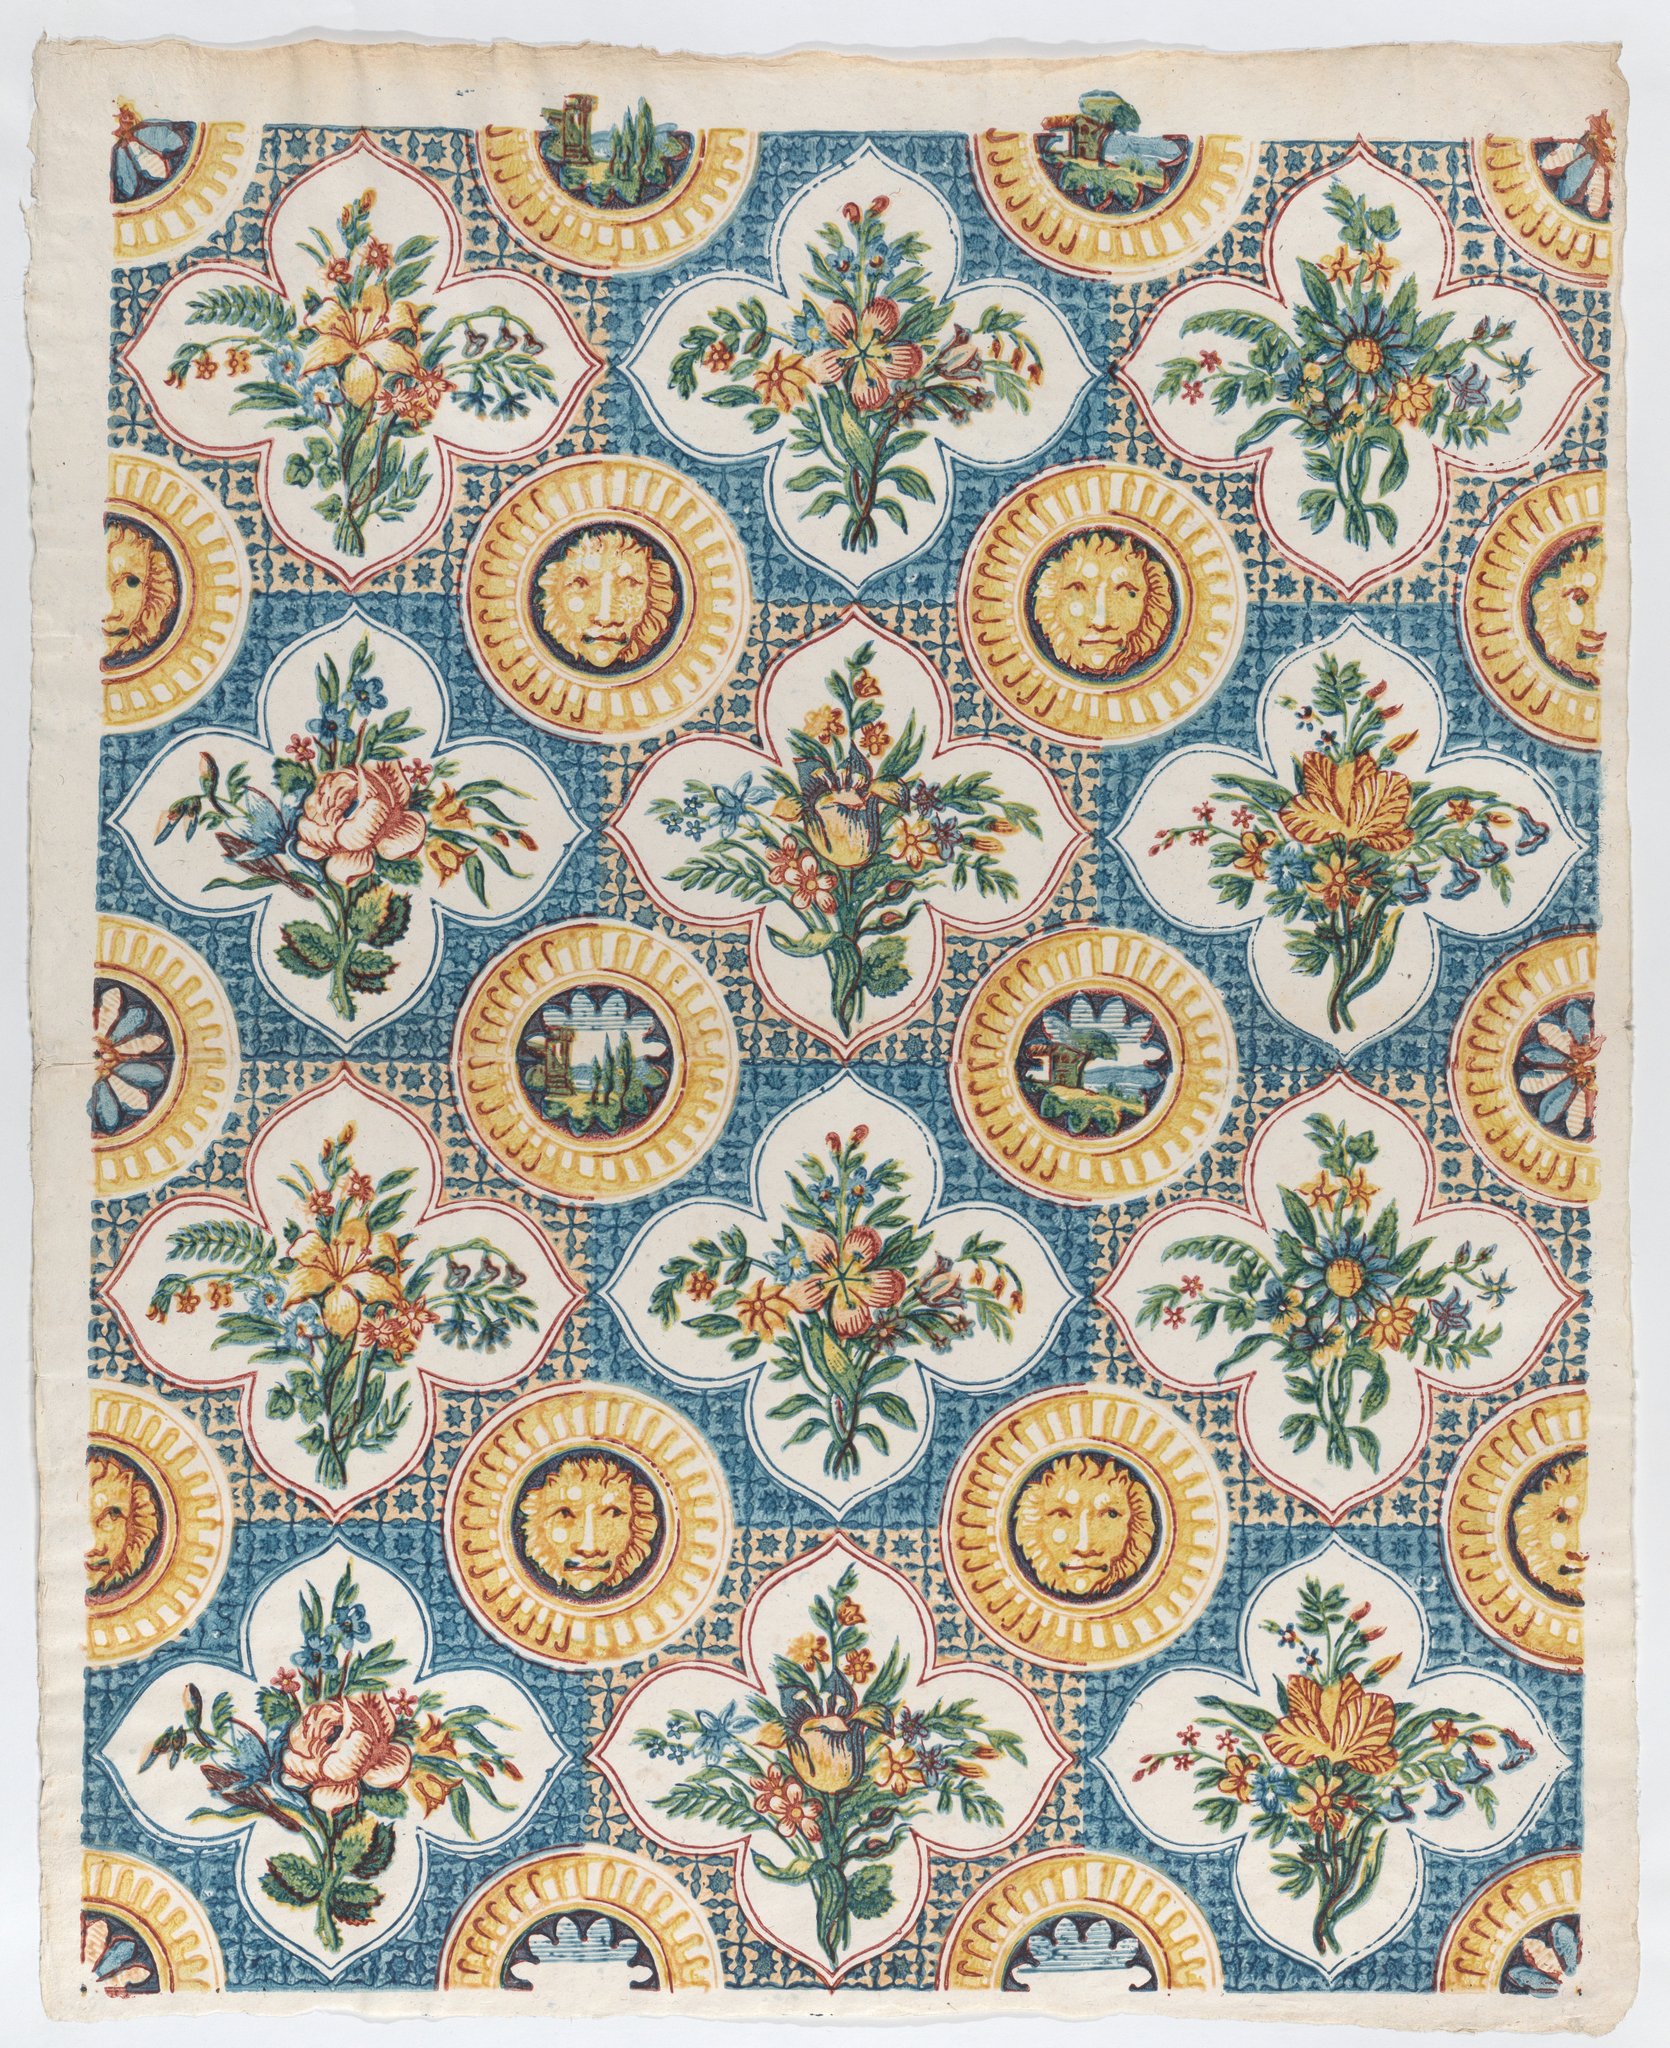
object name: print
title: Sheet with pattern of bouquets and lion heads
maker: Anonymous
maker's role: artist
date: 1767-1866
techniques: relief print